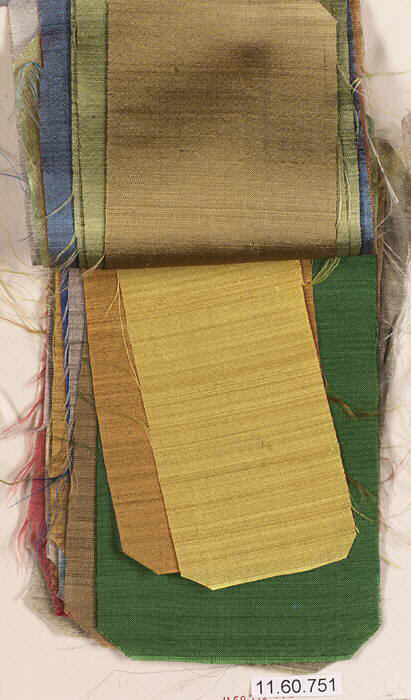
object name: sample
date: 1801-1833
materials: silk